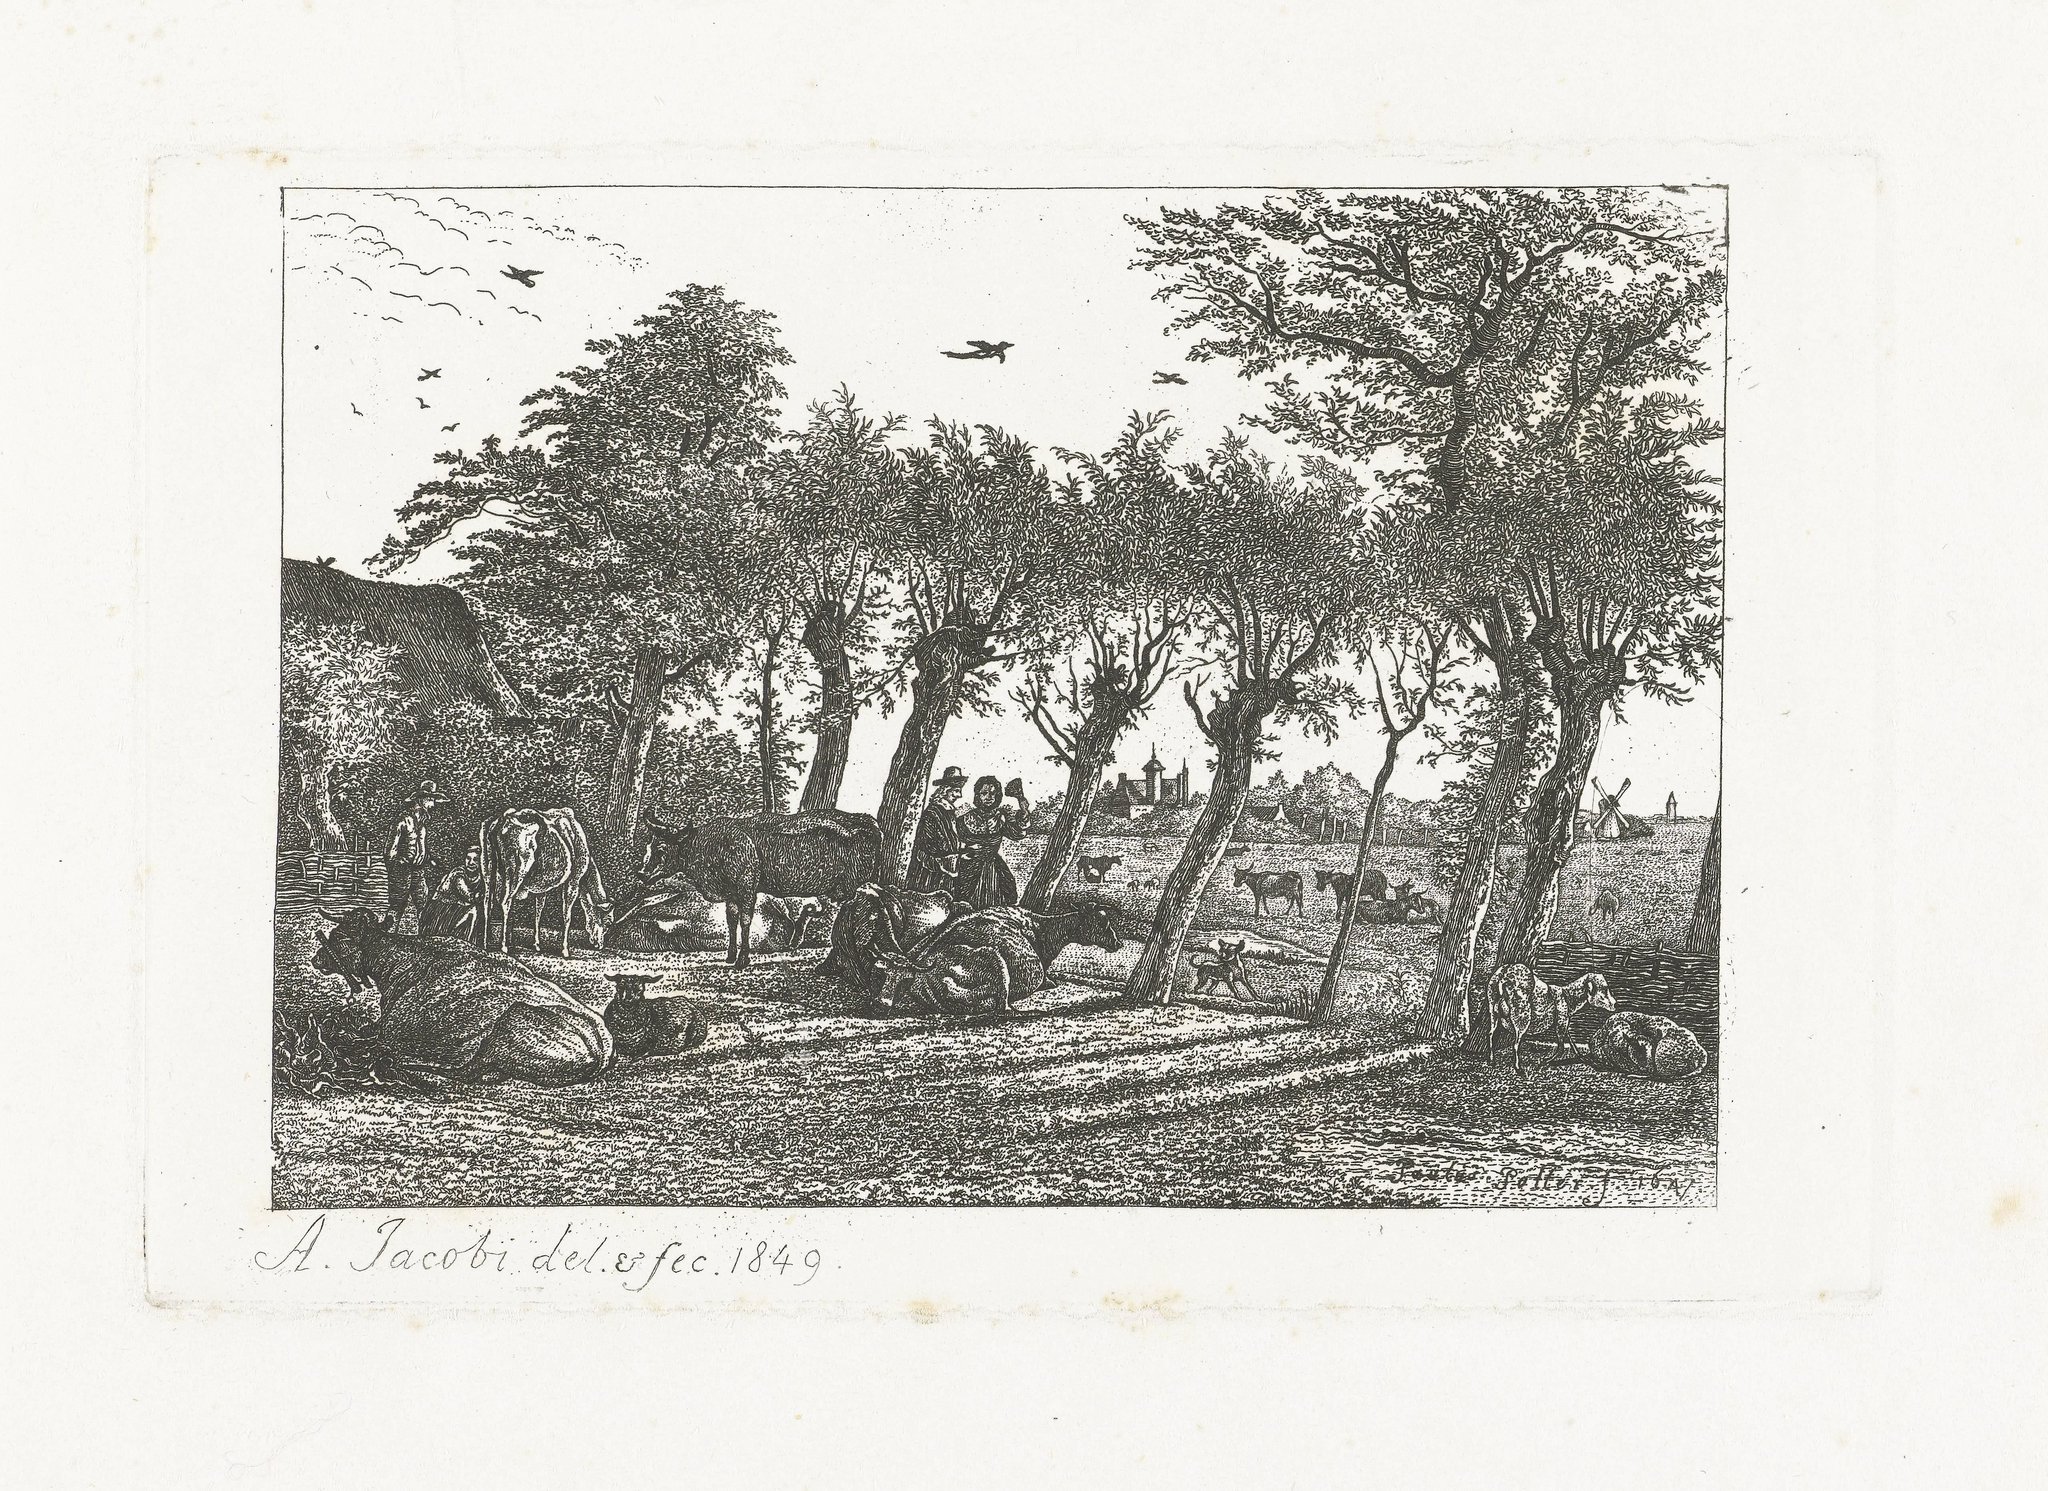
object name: print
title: Weiland met koeien en schapen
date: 1849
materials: paper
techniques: etching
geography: rotterdam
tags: cow, meadow, pasture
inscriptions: collector's mark: Lugt 2227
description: Weiland met koeien, schapen en rij knotwilgen. Links een boerderij, daarnaast een vrouw een koe melkend en in het midden bij de knotwilgen een wandelend echtpaar. Op de achtergrond een kerk en molen. Latere druk van een ets van Paulus Potter uit 1647.